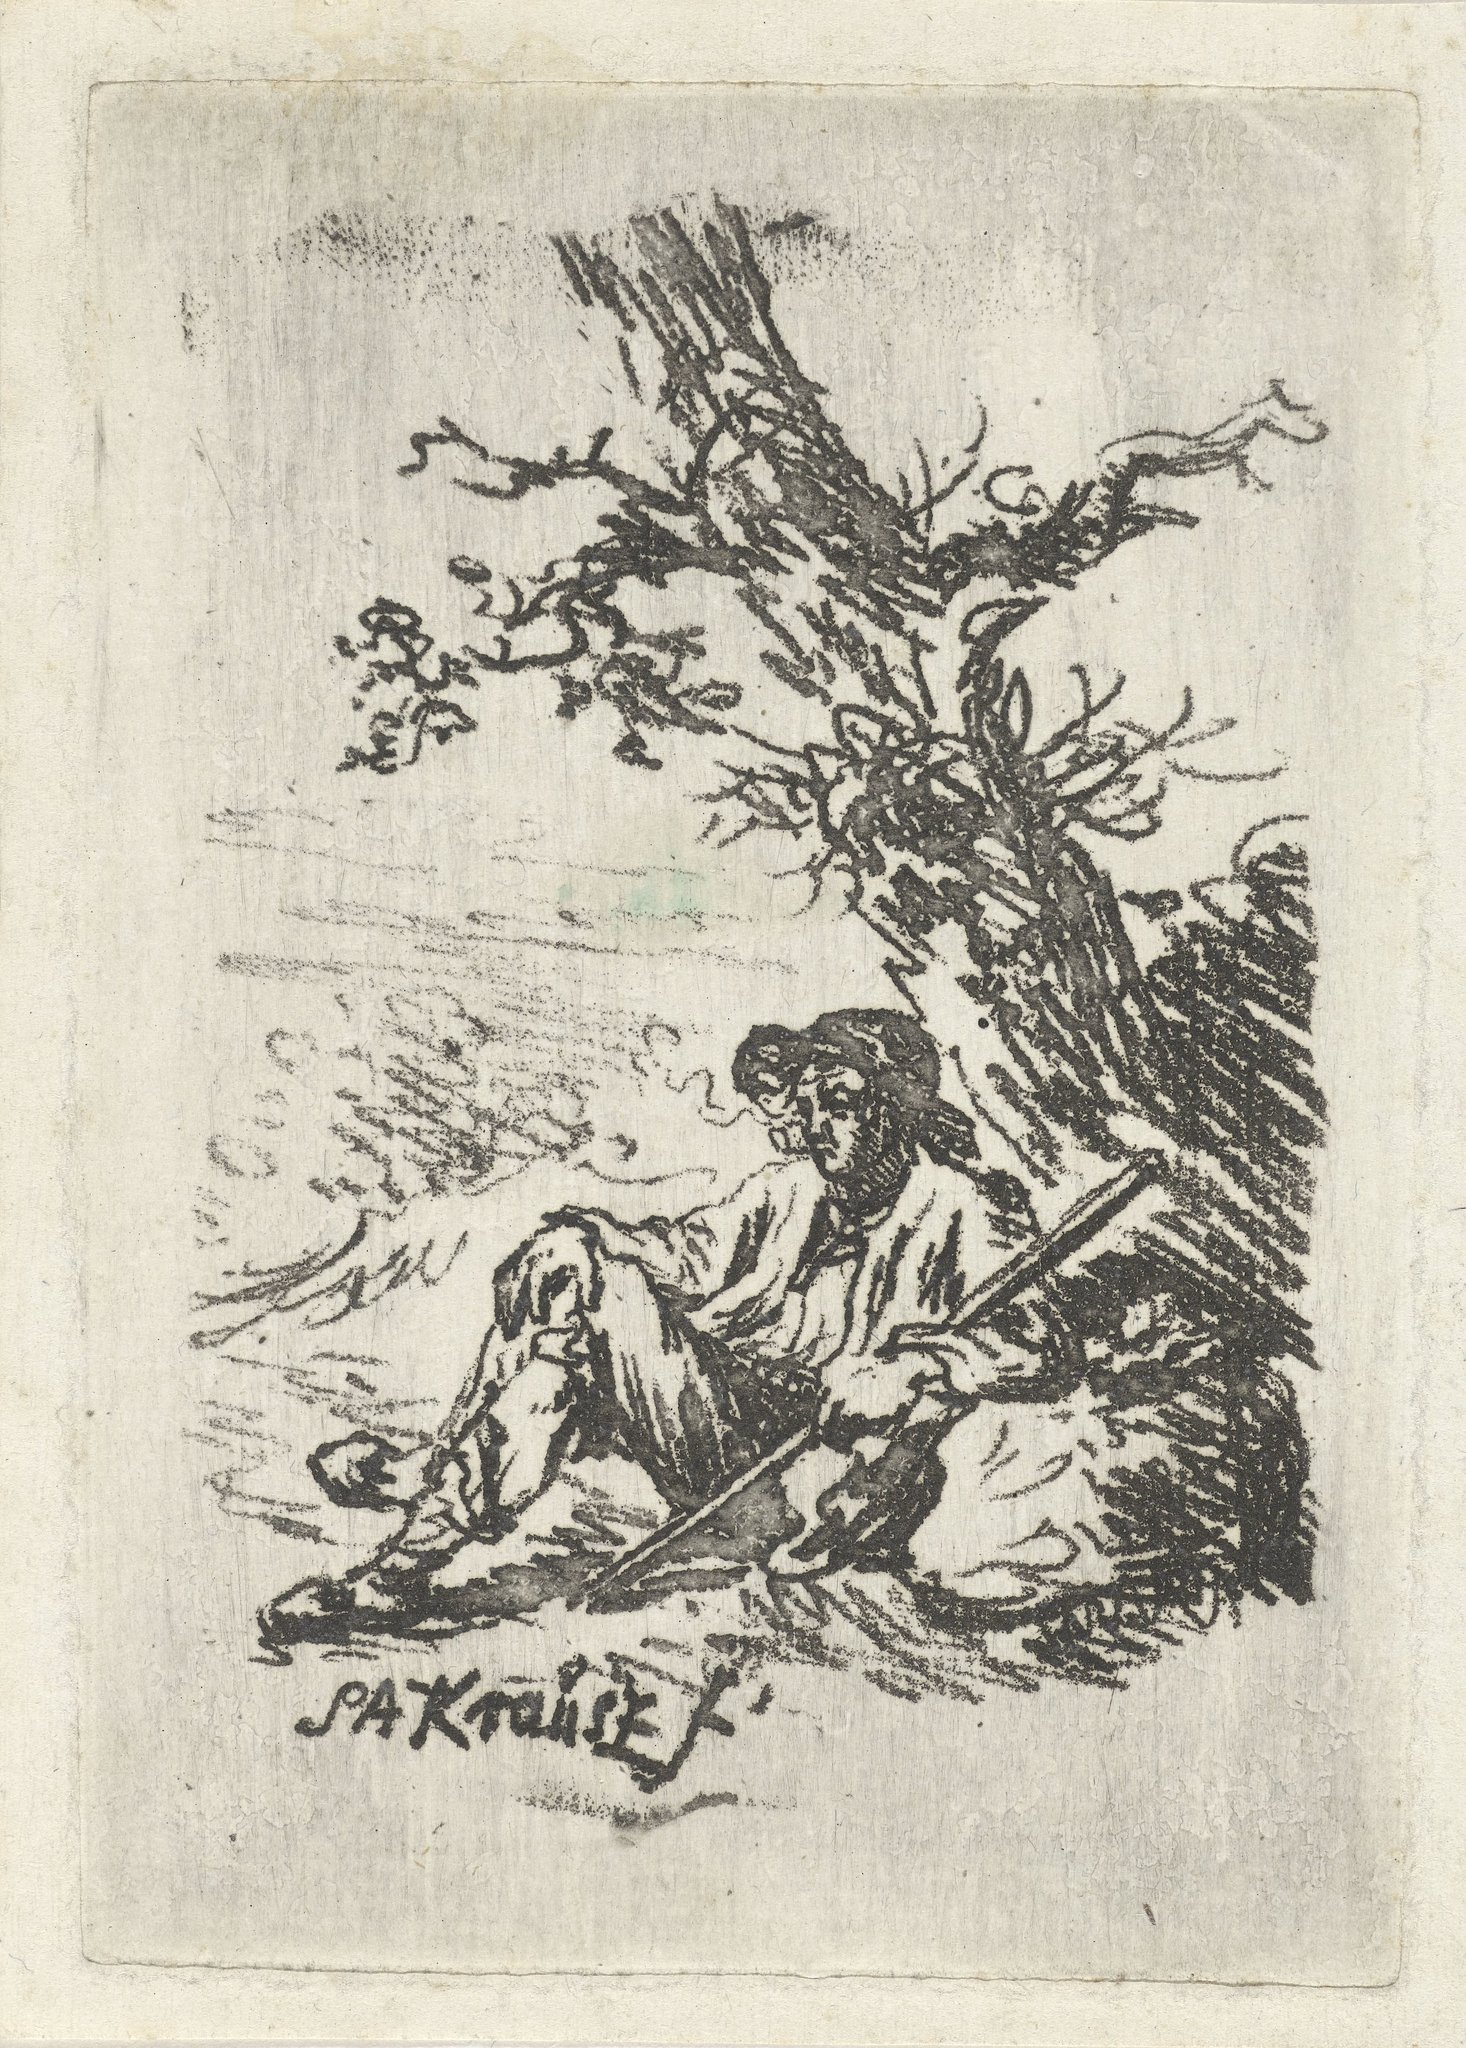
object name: print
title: Rustende onder een boom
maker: simon andreas krausz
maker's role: draughtsman, print maker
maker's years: 1760-1825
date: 1770-1825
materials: paper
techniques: printmaking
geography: the hague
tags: trees, herding, herdsman, herdswoman, shepherd, shepherdess, cowherd, etc., pipe ~ tobacco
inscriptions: collector's mark: Lugt 2228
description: In een landschap zit een herder onder een boom. Hij draagt een hoed, rookt een pijp en houdt een stok in de hand.